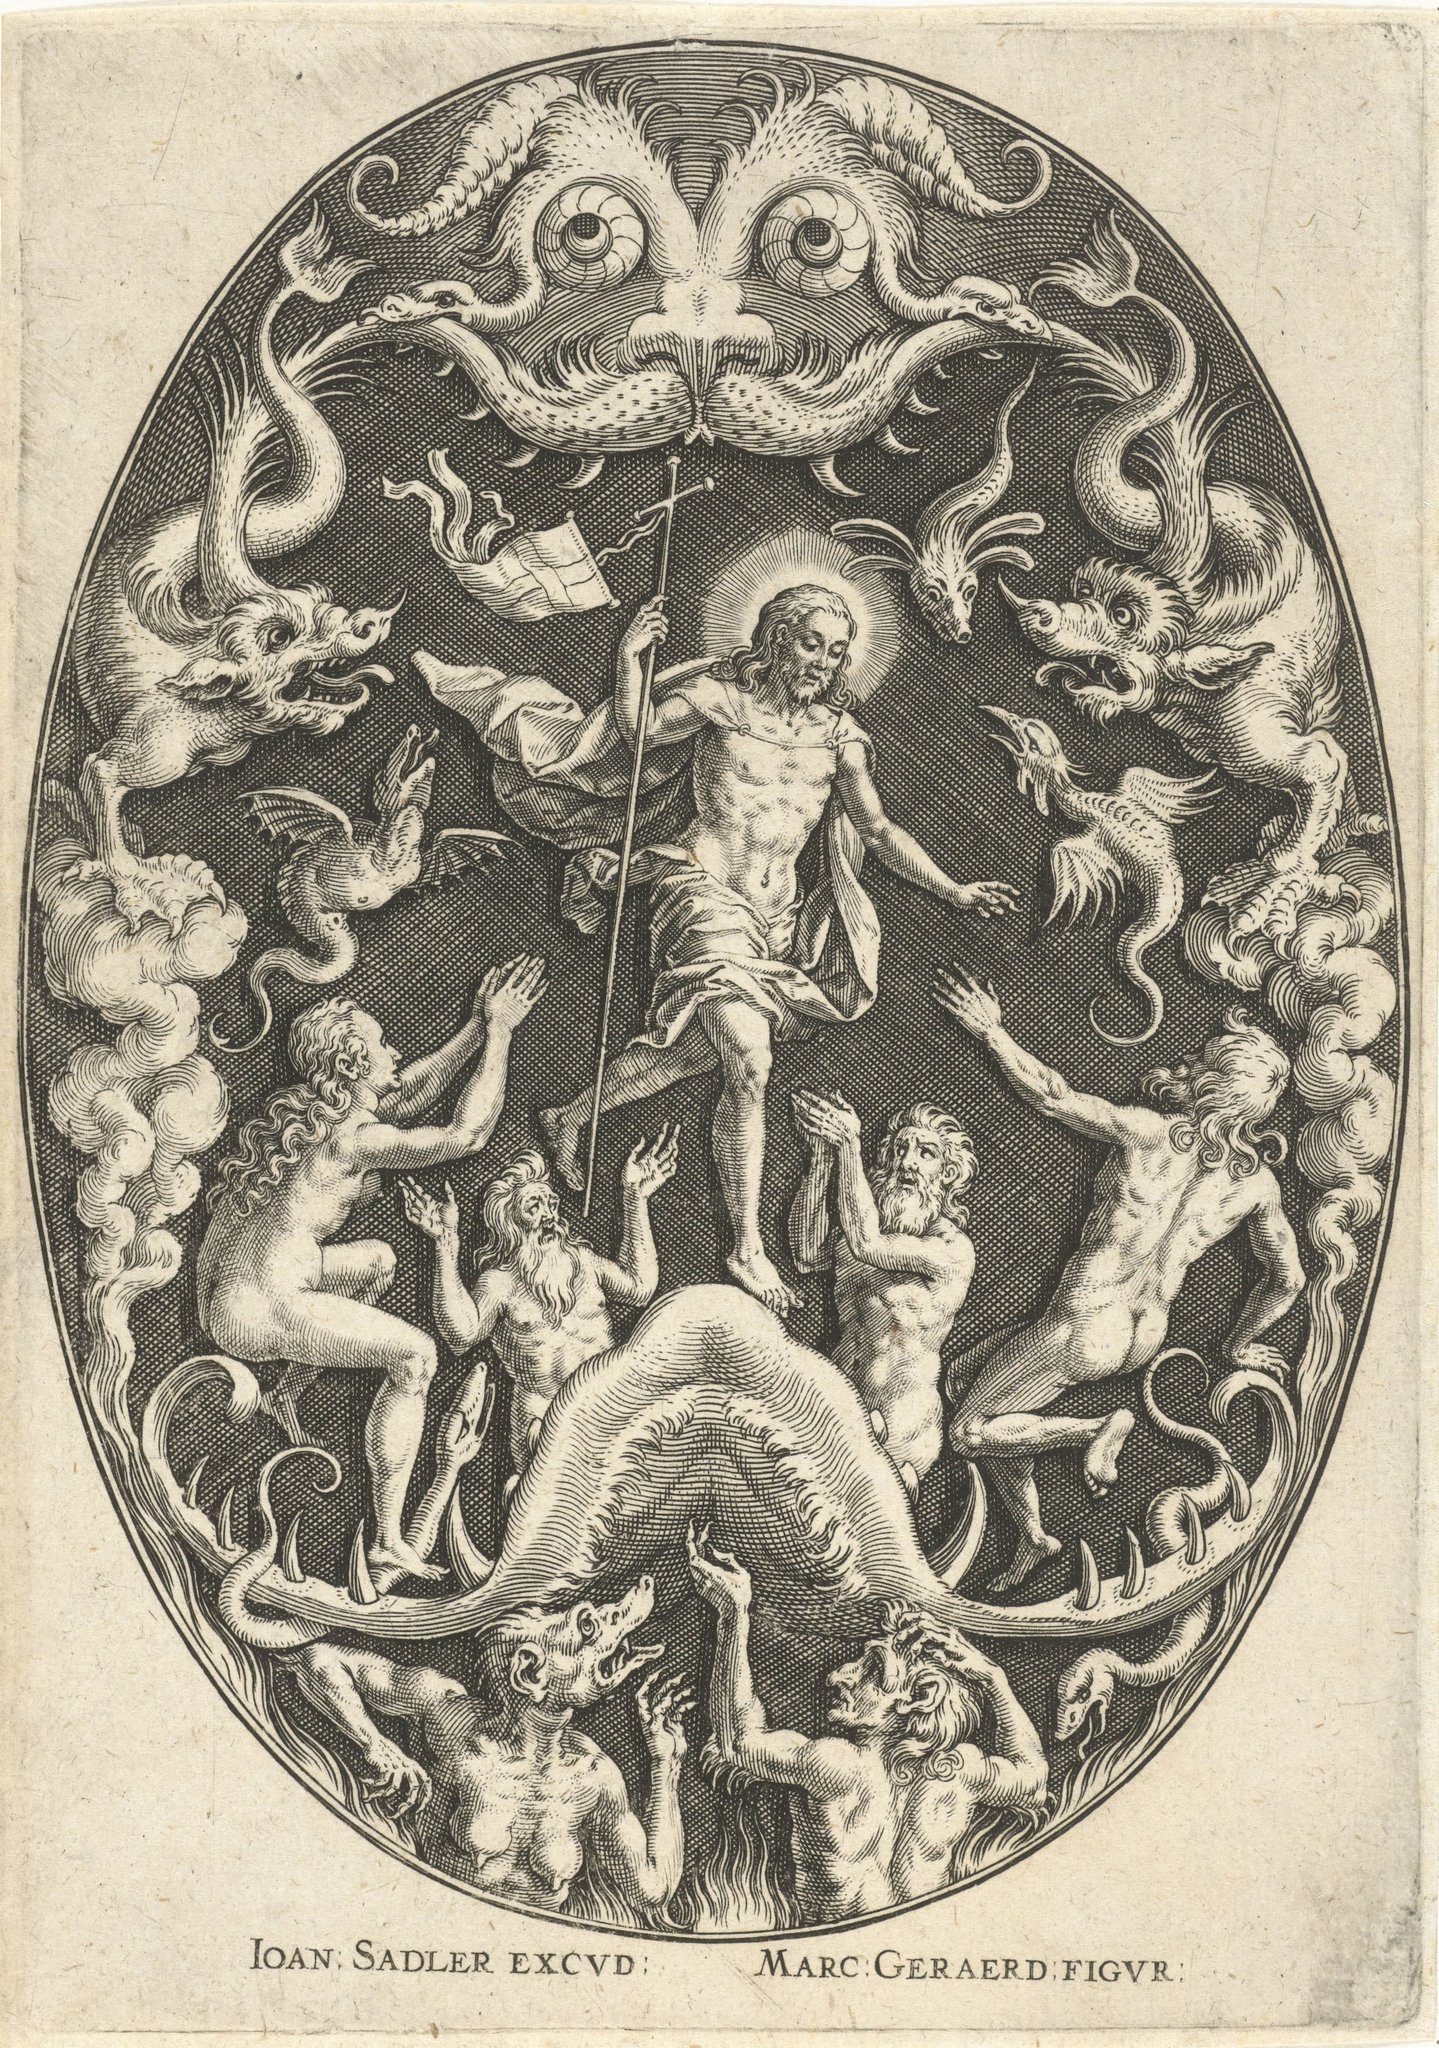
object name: ornament print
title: Passio verbigenae quae nostra redemptio Christi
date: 1560-1600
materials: paper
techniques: engraving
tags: ornaments ~ art, christ arrives at the entrance of hell and breaks the door(s)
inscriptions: collector's mark: Lugt 2228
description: Christus' afdaling in het voorgeborchte na zijn dood. Onder hem de hellemond en duivels. Hij reikt de hand aan oudtestamentische heiligen. In staand ovaal met ornament. De laatste prent van een dertiendelige serie ornamentprenten over de passie van Christus.